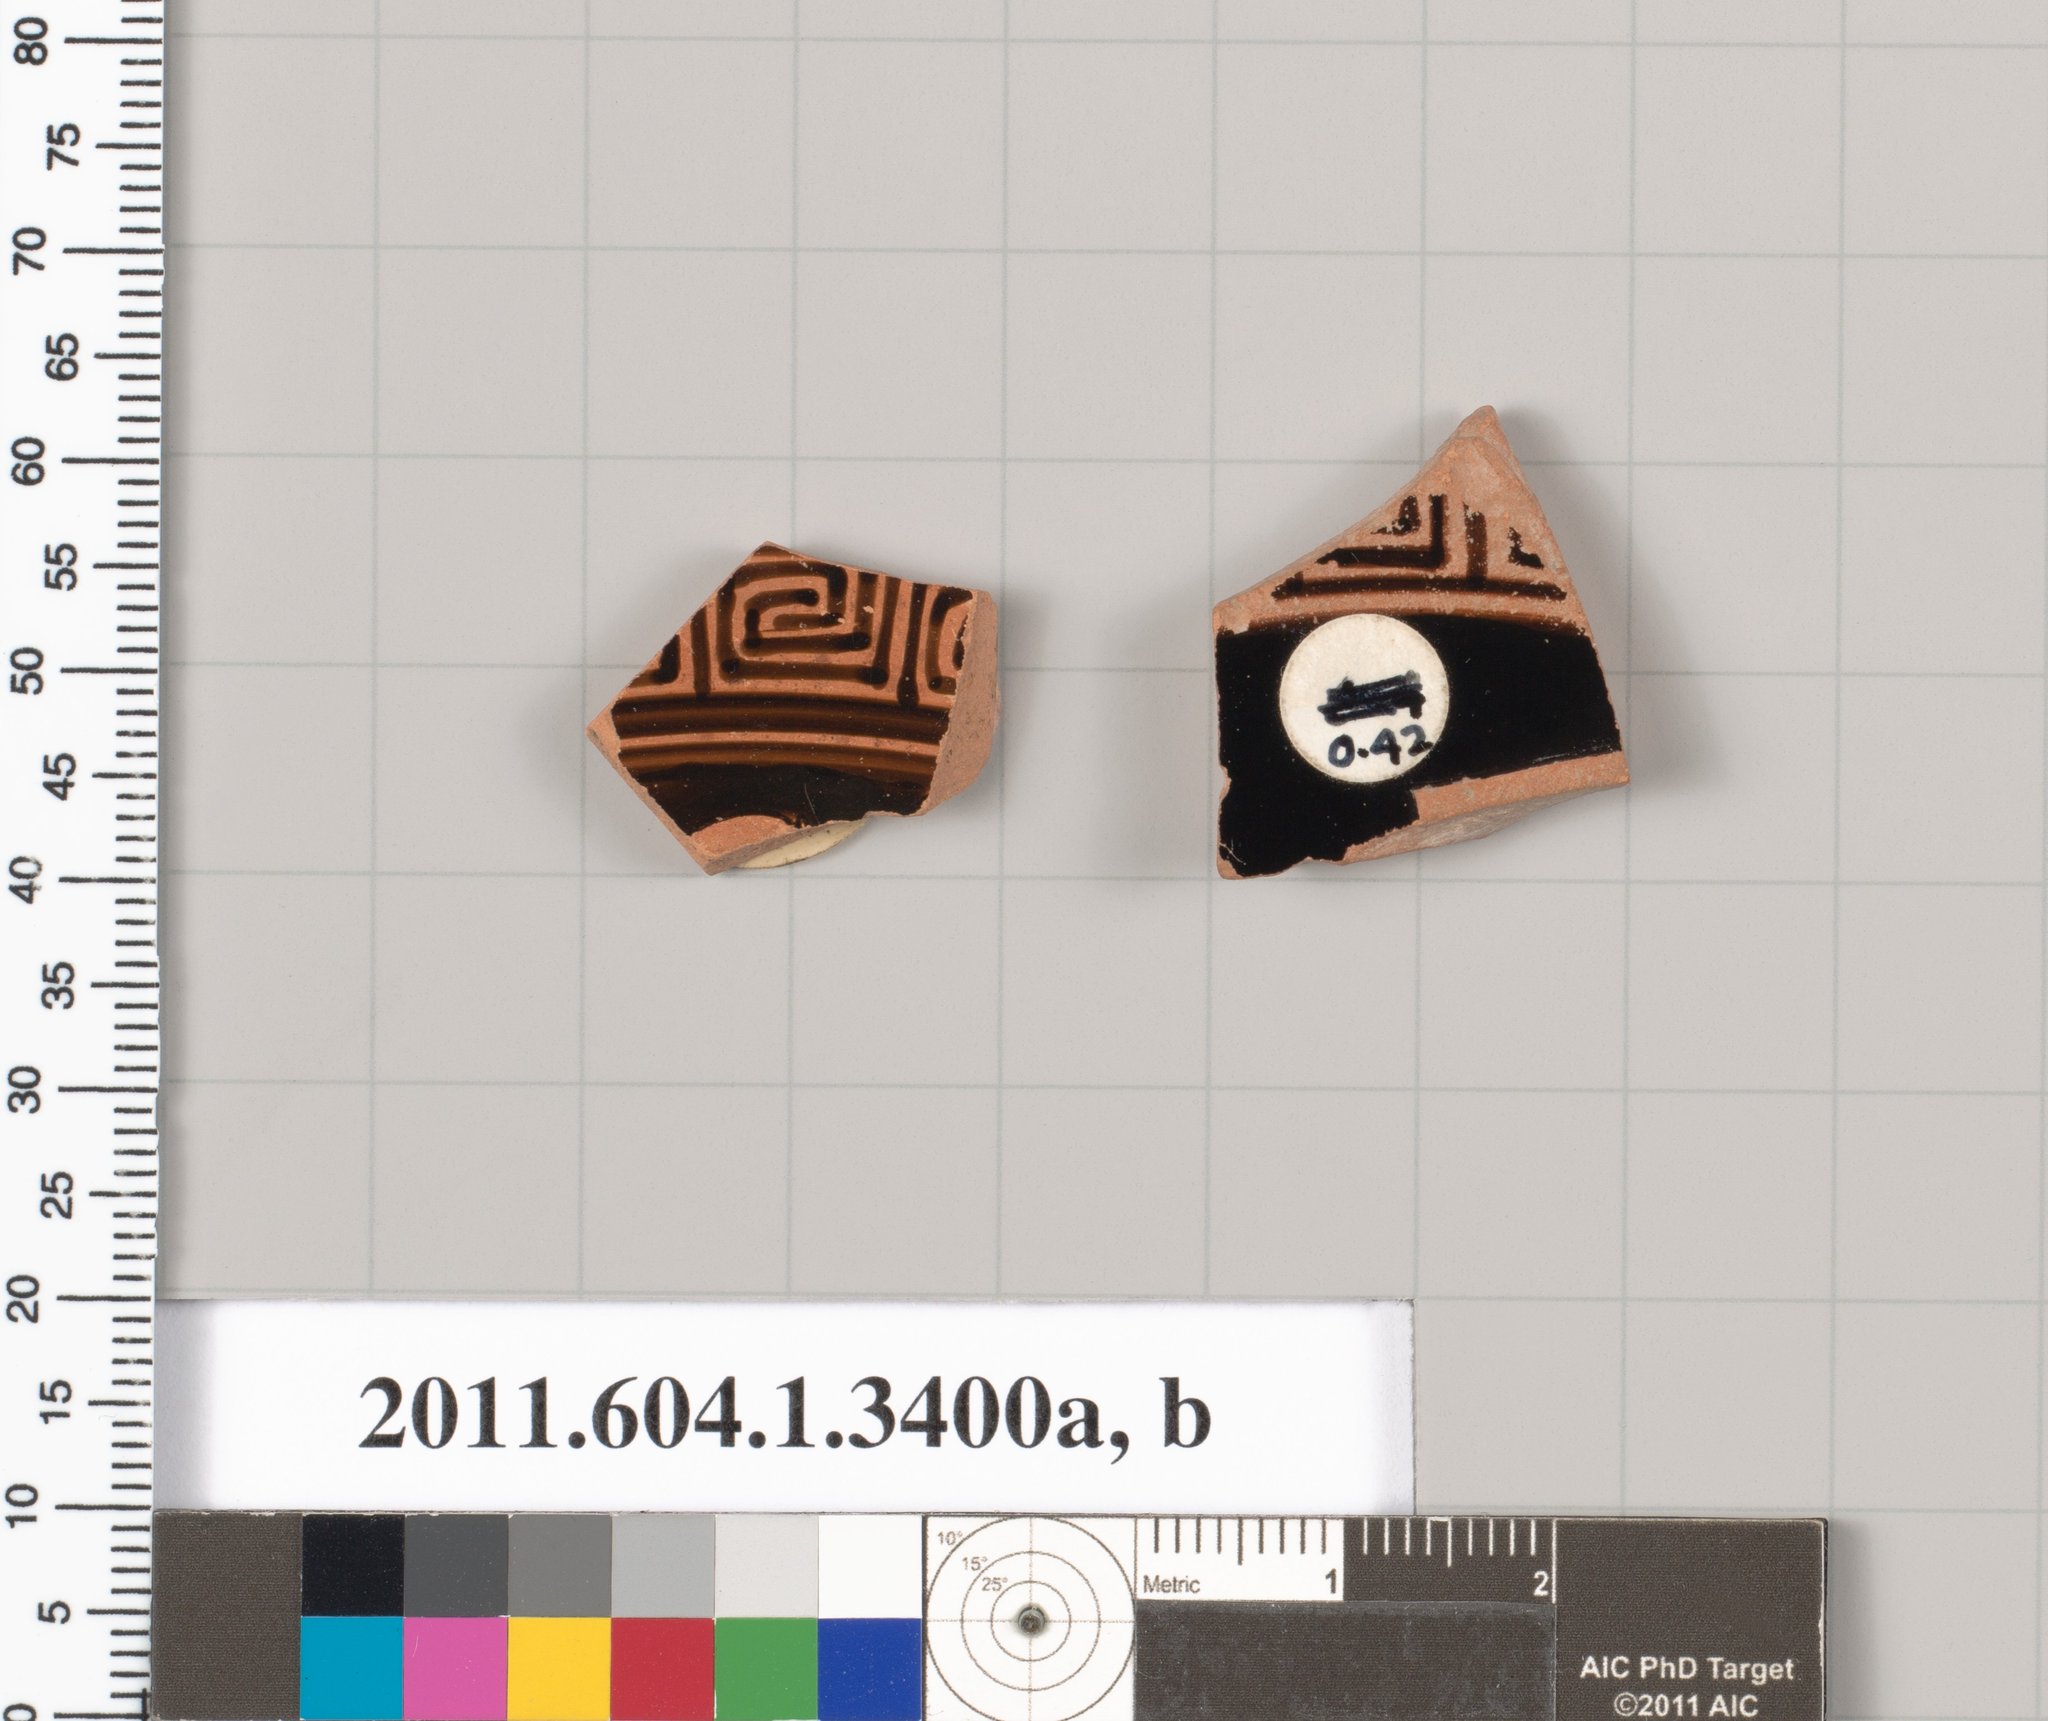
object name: kylix fragment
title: Terracotta fragments of kylikes (drinking cups)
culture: greek, attic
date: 500-470 BCE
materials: terracotta